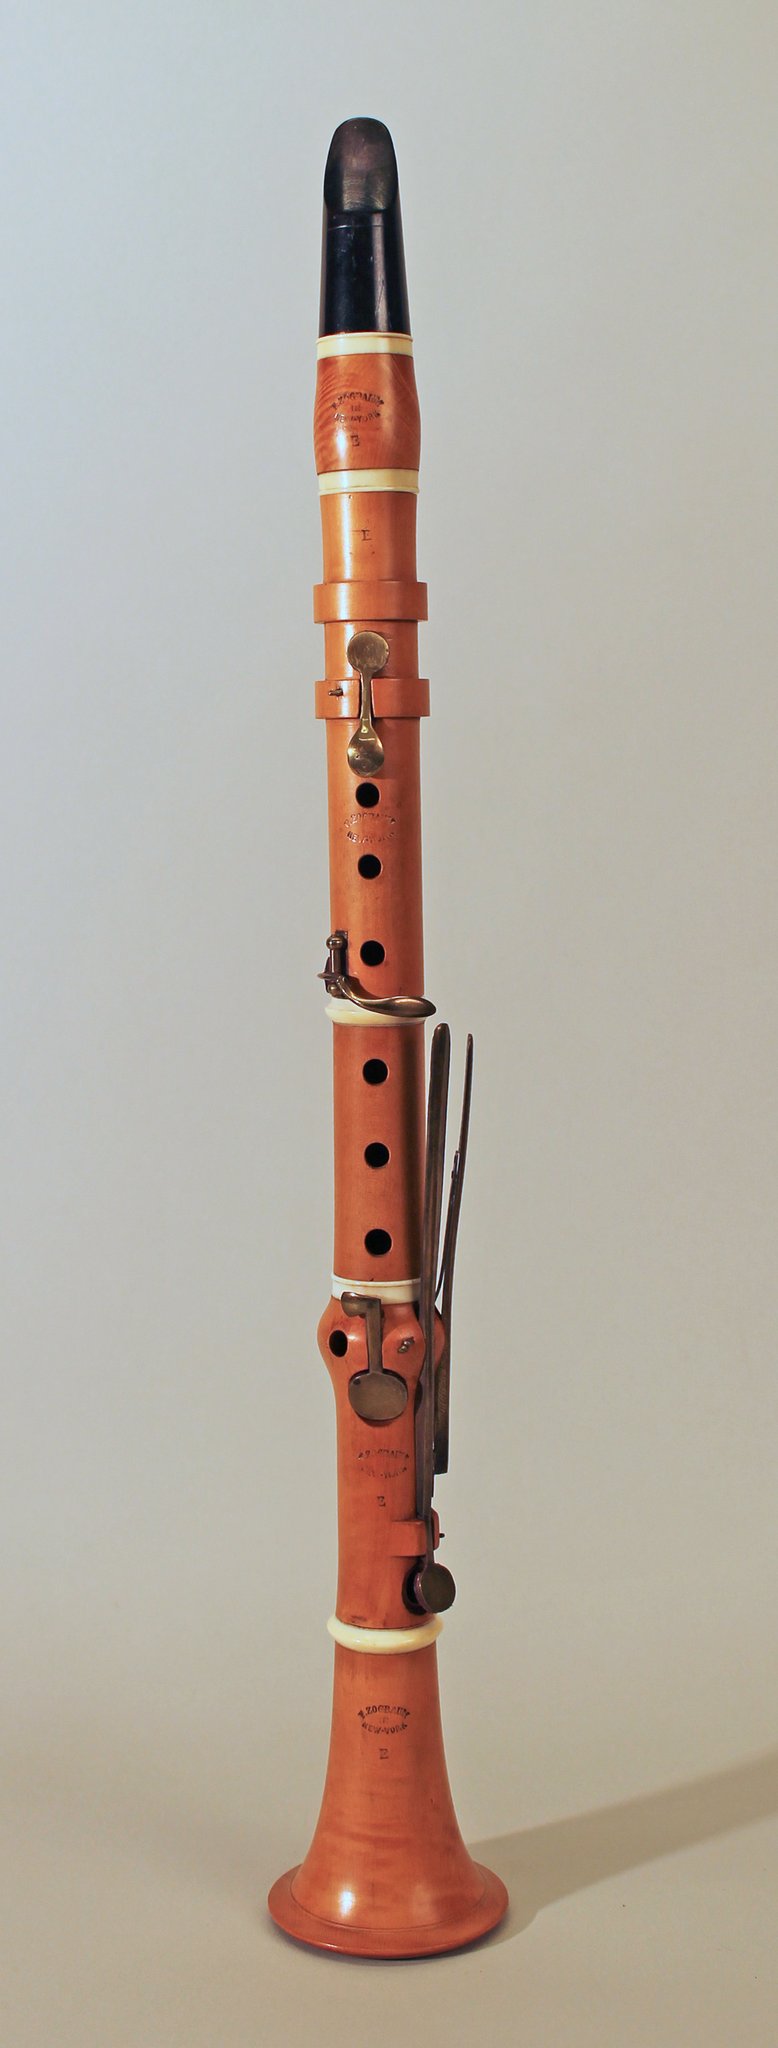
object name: clarinet in e flat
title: Clarinet in E-flat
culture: american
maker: ferdinand zogbaum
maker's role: maker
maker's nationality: american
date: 1855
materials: wood, brass, ivory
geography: united states